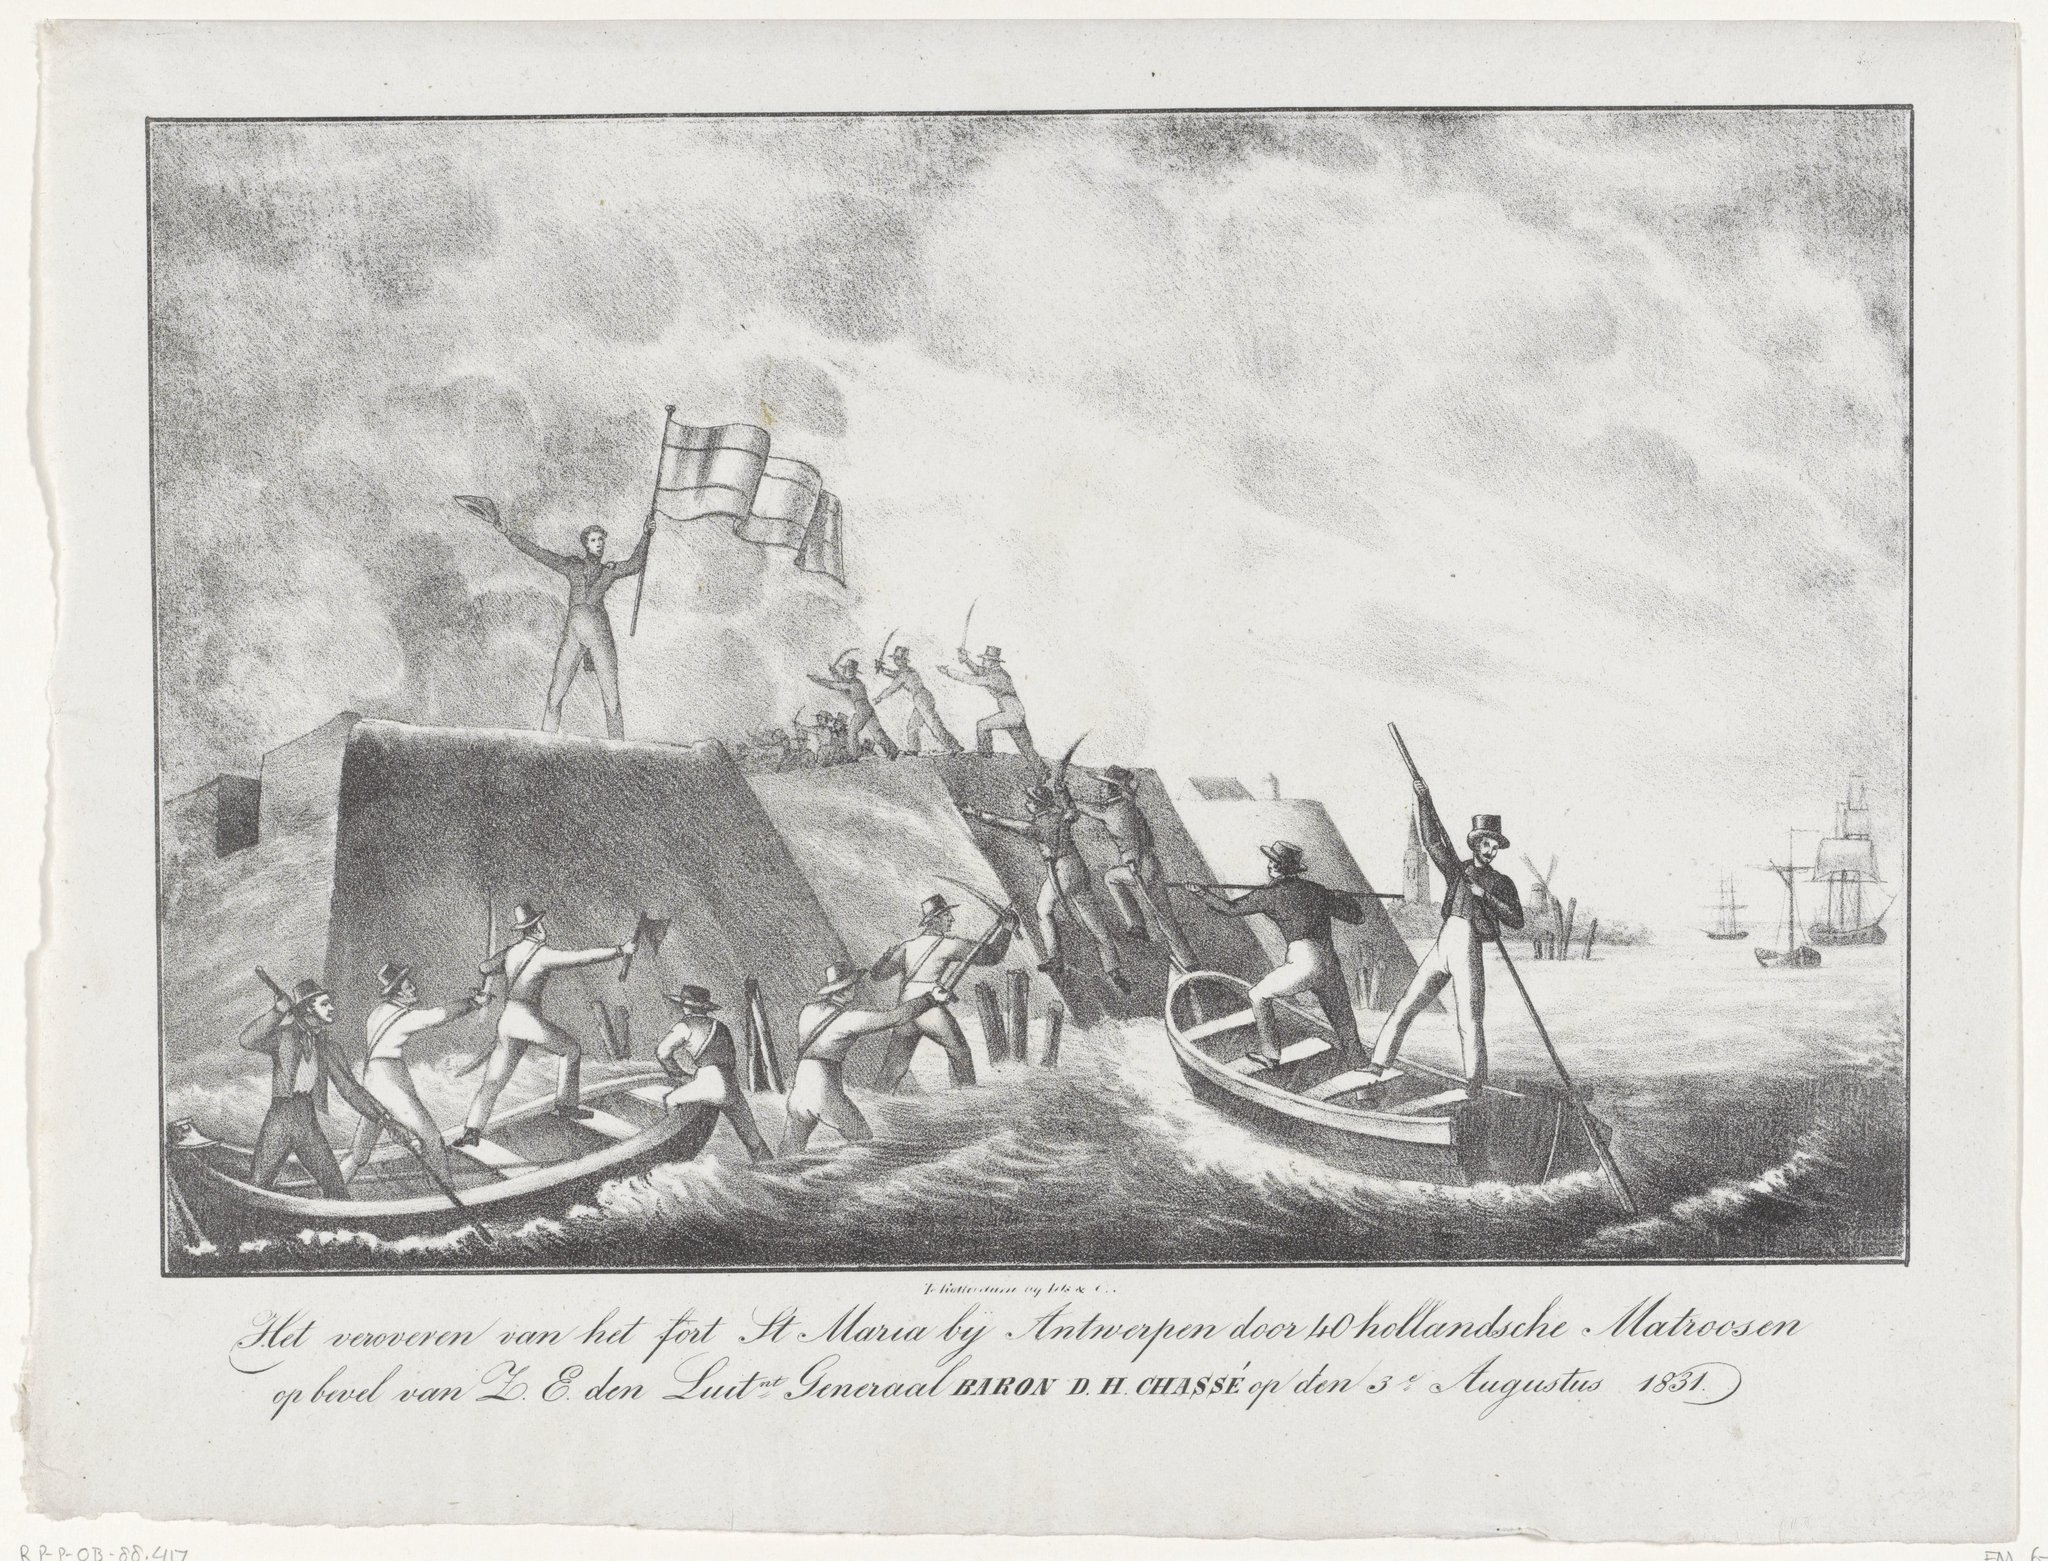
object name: print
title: Het veroveren van het fort St Maria bij Antwerpen door 40 hollandsche Matroosen op bevel van Z.E. den Luit.nt Generaal Baron D.H. Chassé op den 3e Augustus 1831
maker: Anonymous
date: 1831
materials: paper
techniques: lithograph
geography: netherlands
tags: david hendrik baron chassé, fortress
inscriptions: collector's mark: Lugt 2228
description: De verovering van het Belgische fort Sint-Marie aan de Schelde door veertig Nederlandse matrozen op bevel van luitenant-generaal Chassé, 3 augustus 1831. Onderdeel van een serie van drie platen.